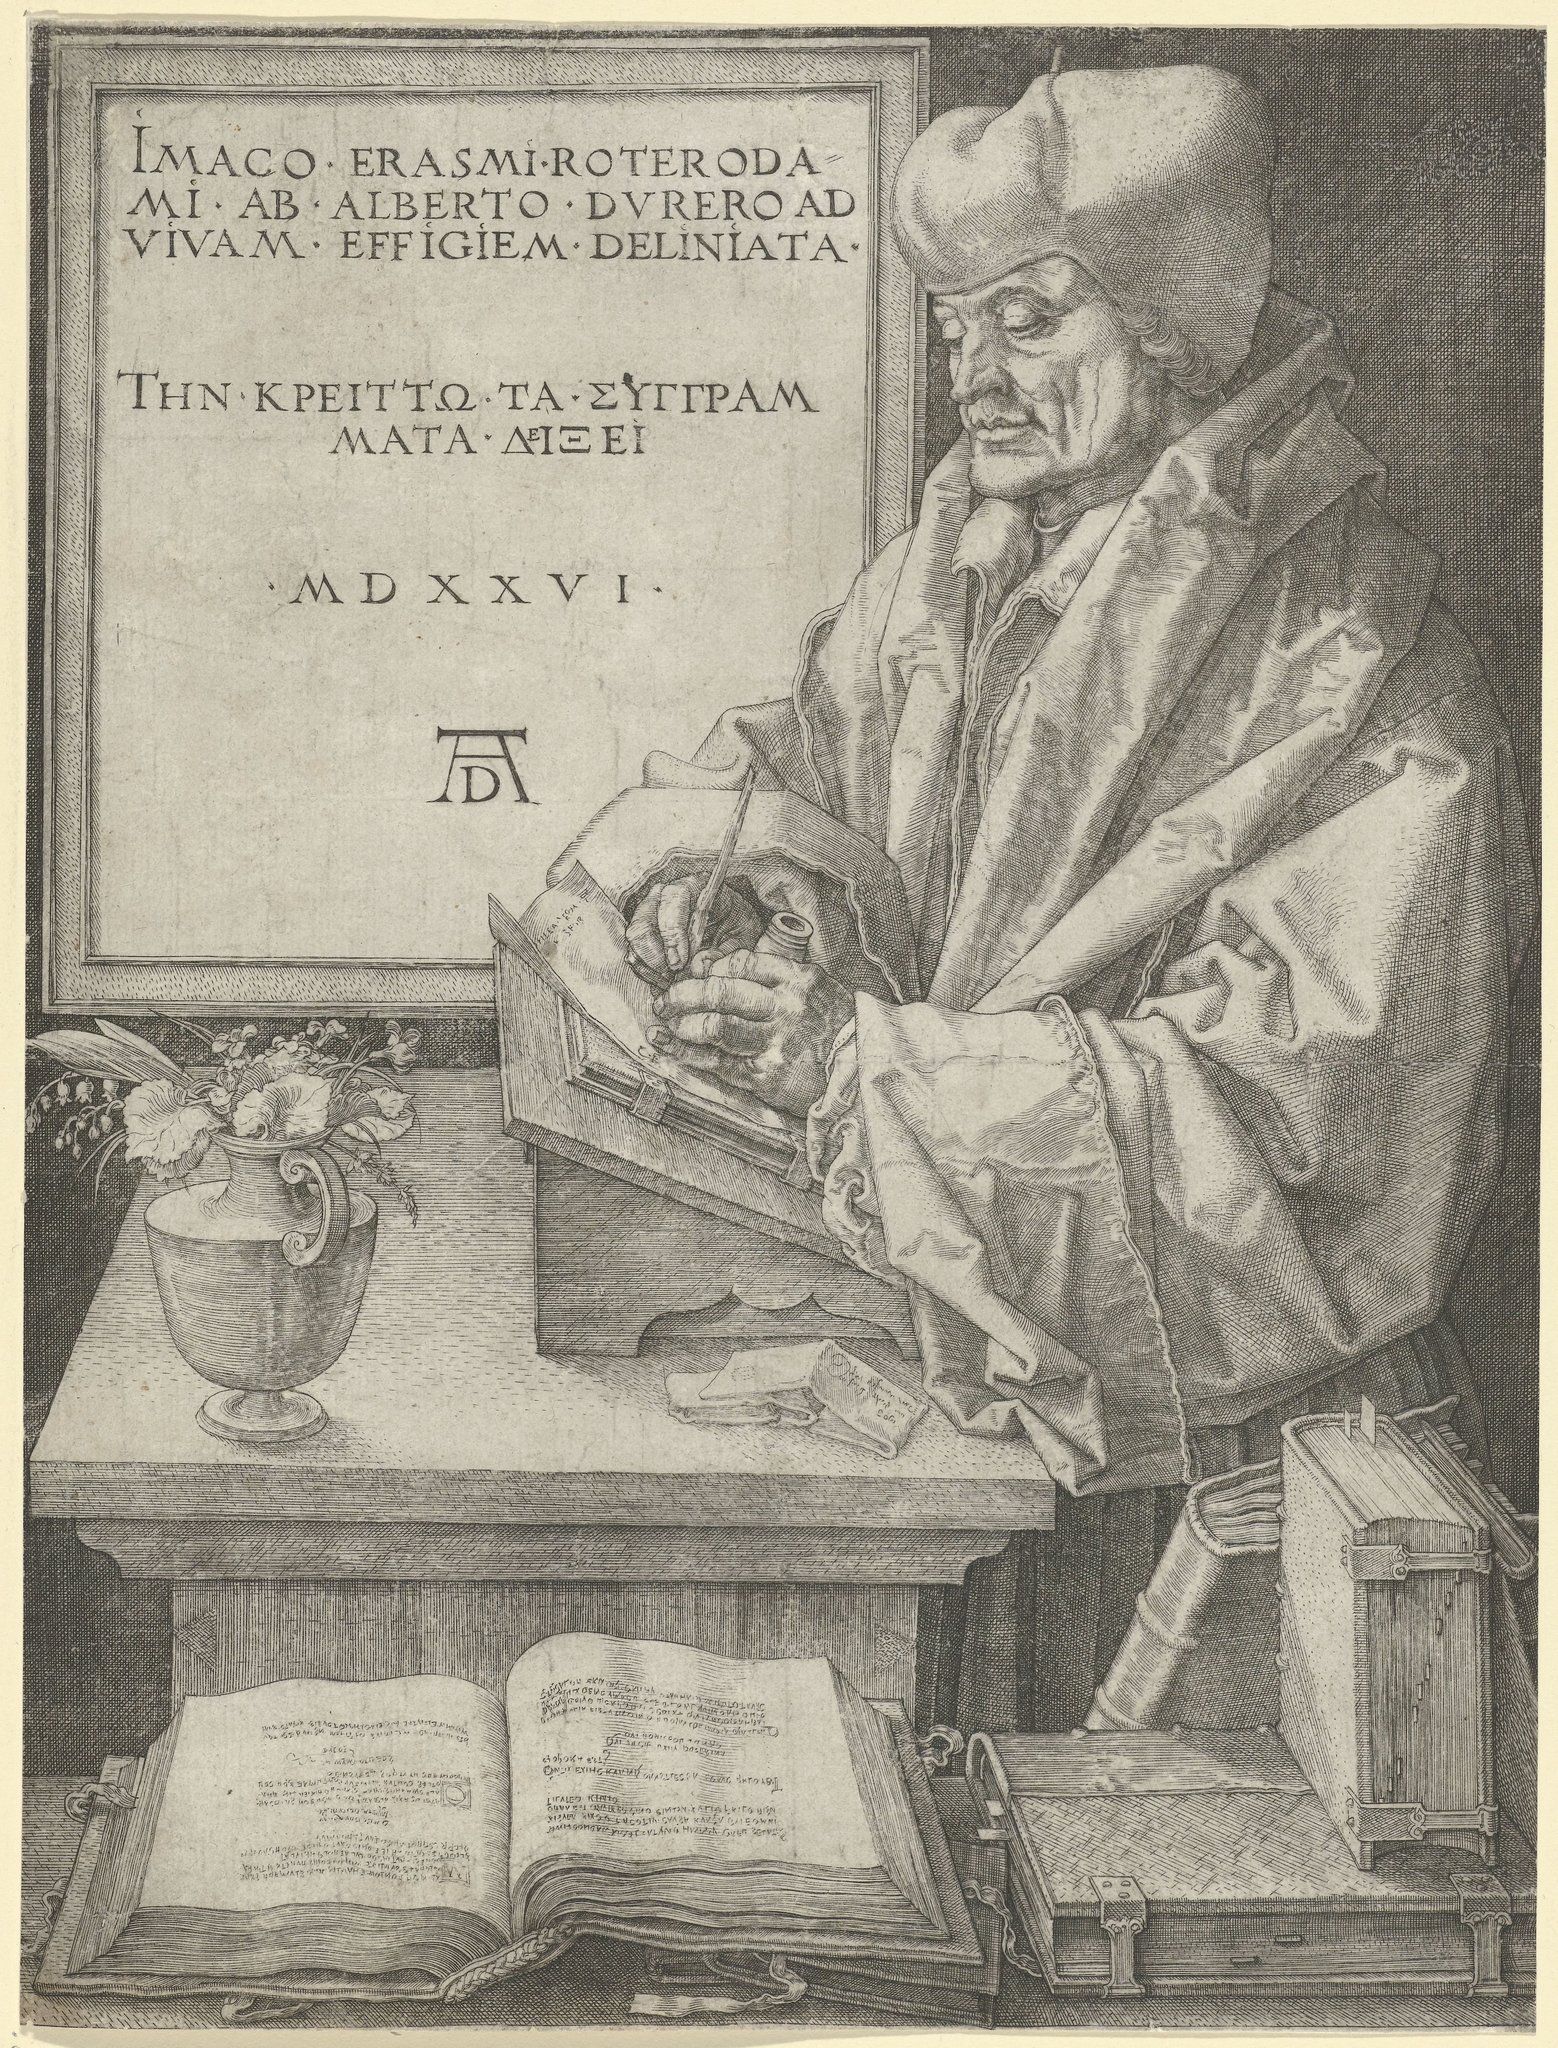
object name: print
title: Portret van Erasmus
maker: albrecht dürer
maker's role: draughtsman, painter, print maker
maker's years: 1471-1528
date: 1526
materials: paper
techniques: engraving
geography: nuremberg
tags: rotterdam, desiderius erasmus, historical persons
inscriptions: number: ‘1215’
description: Portret van Erasmus, schrijvend, staande aan een lezenaar bij een tafel waarop een vaas met bloemen staat. Achter de tafel een tablet aan de wand met Latijnse tekst.